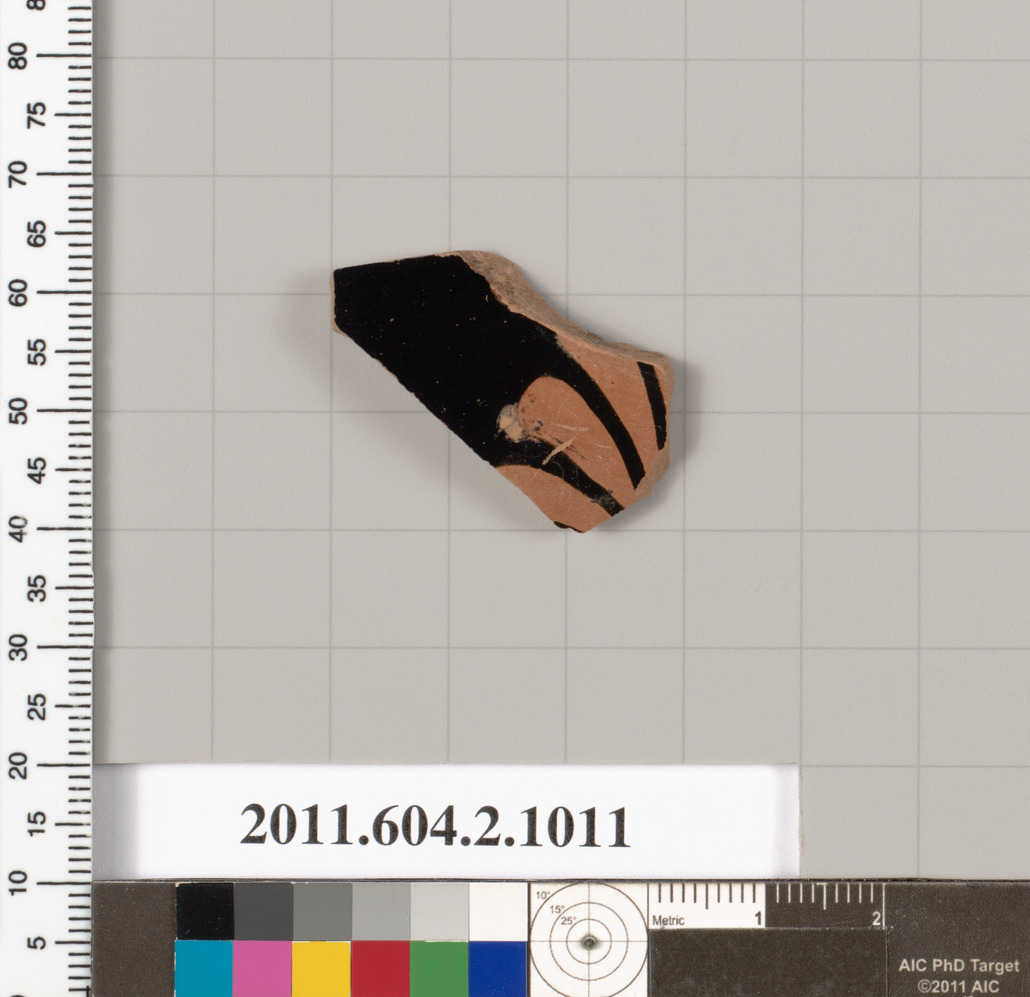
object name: oinochoe fragment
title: Terracotta fragment of an oinochoe (jug)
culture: greek, attic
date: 460-440 BCE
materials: terracotta